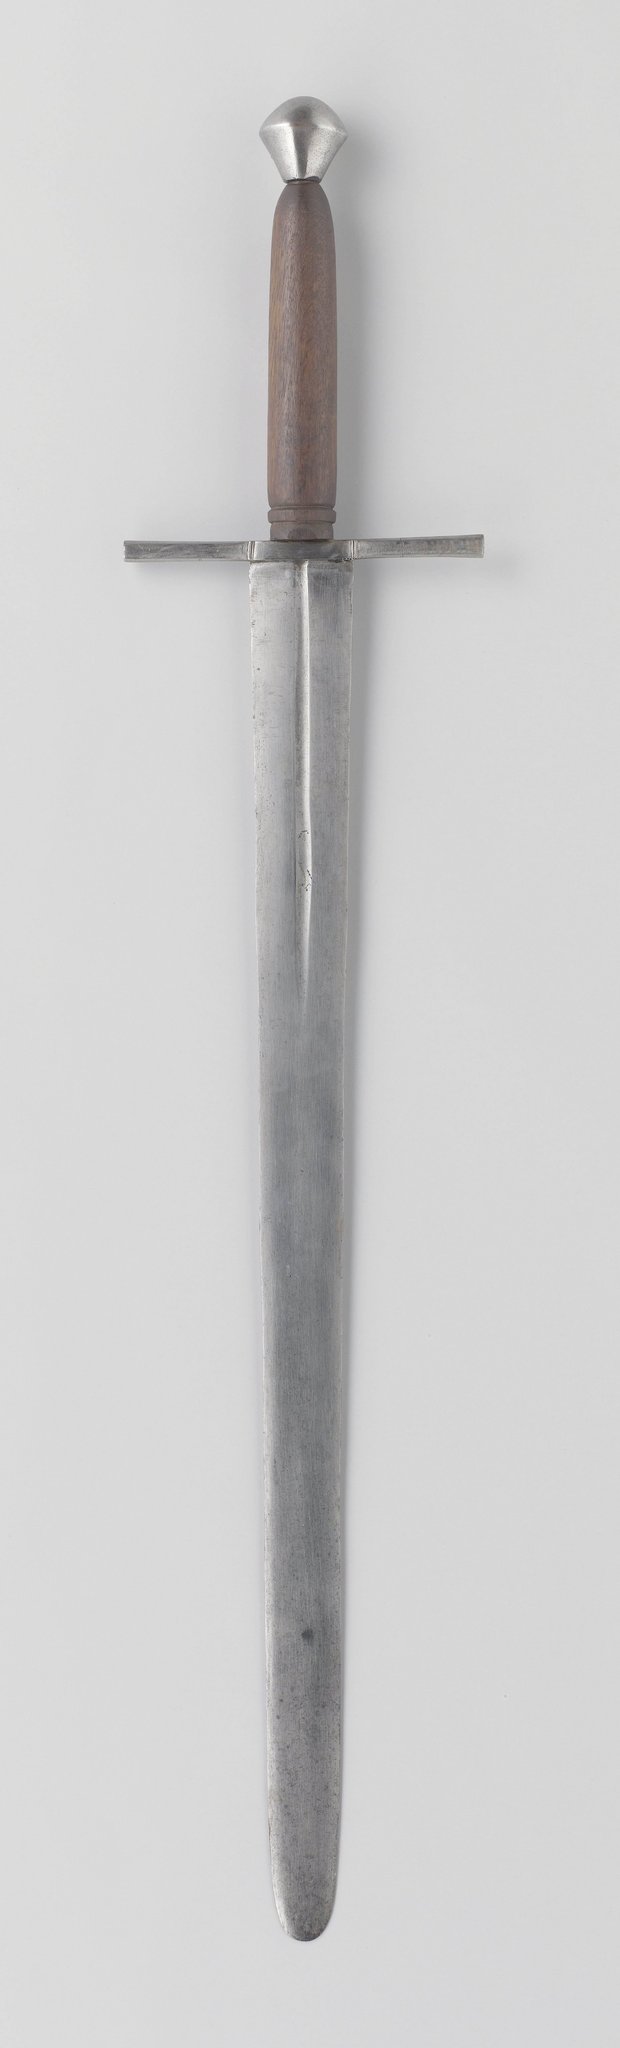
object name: executioner's sword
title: Beulszwaard van het Gerechtshof, Den Haag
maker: Anonymous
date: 1500-1700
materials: iron, wood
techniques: forging, striking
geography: low countries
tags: the hague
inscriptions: mark: ‘liggend kroontje en fragmenten van Solinger wolf’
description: Beulszwaard met houten gevest, aan beide zijden scherp snijgedeelte, bovenaan knop, onder gevest uitsteeksels. Afkomstig van het Gerechtshof, Den Haag.